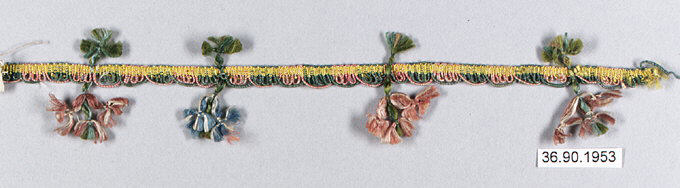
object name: fringe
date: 1767-1800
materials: silk